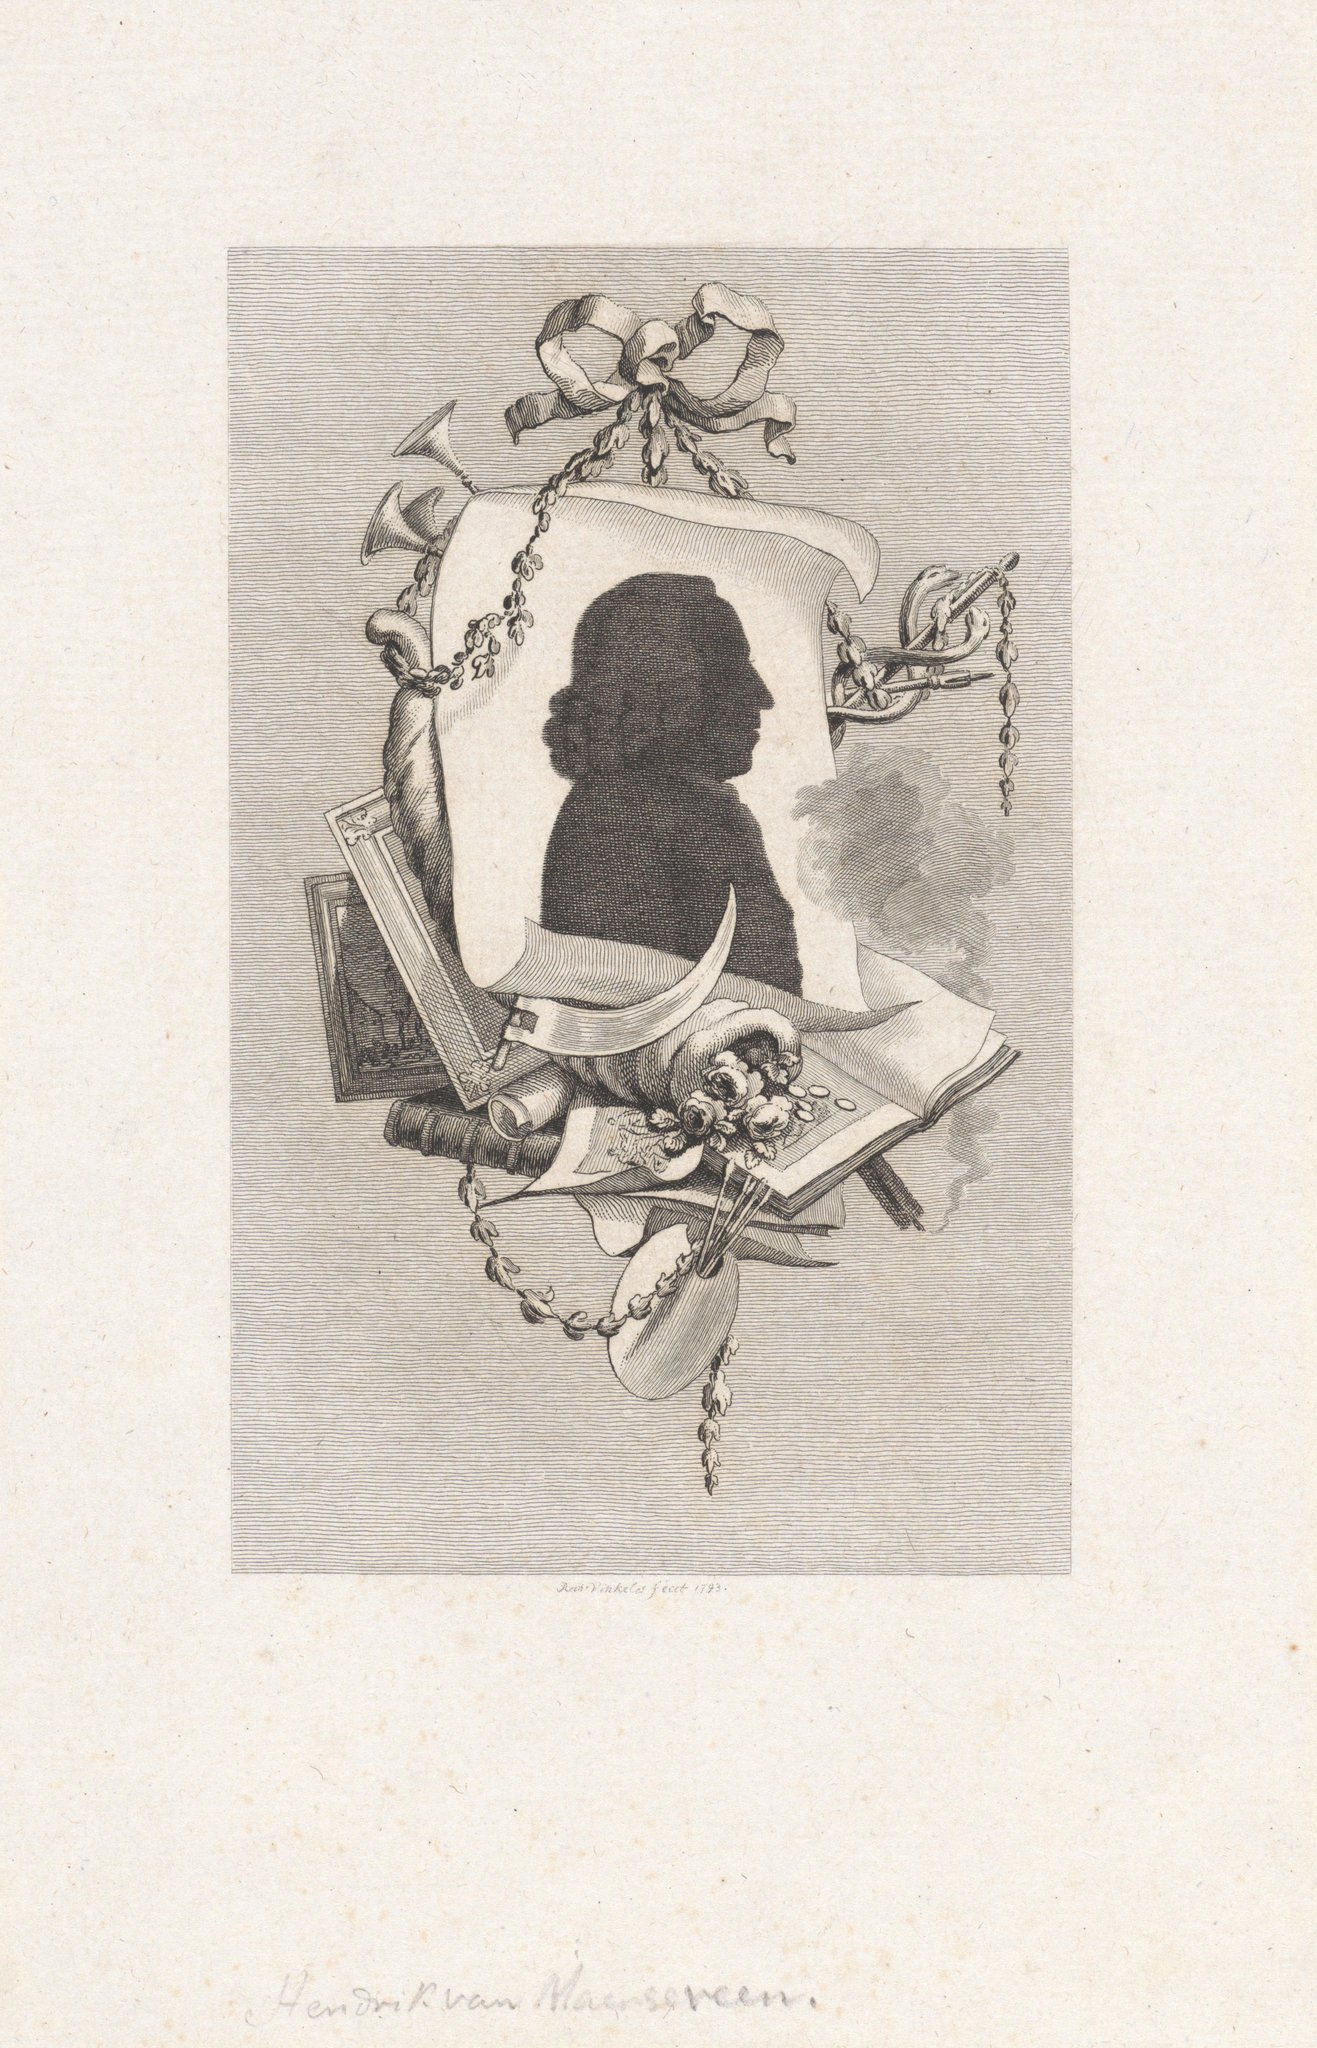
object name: print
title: Silhouet van Hendrik van Maarseveen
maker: reinier vinkeles (i)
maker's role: draughtsman, print maker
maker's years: 1741-1816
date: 1793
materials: paper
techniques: etching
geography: amsterdam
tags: amsterdam, print maker, draughtsman, hendrik van maarseveen, drawing, sketch, 'cornucopia', horn of plenty, palette, caduceus (staff with two snakes, attribute of mercury), frame of painting, etc.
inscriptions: collector's mark: Lugt 240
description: Silhouet van de kunstenaar Hendrik van Maarseveen. Naast het portret een gedoofde fakkel. Bovenaan bazuinen en een caduceus, het attribuut van Mercurius. Onderaan een hoorn des overlvloeds en schilderijen, tekeningen en een prentalbum.